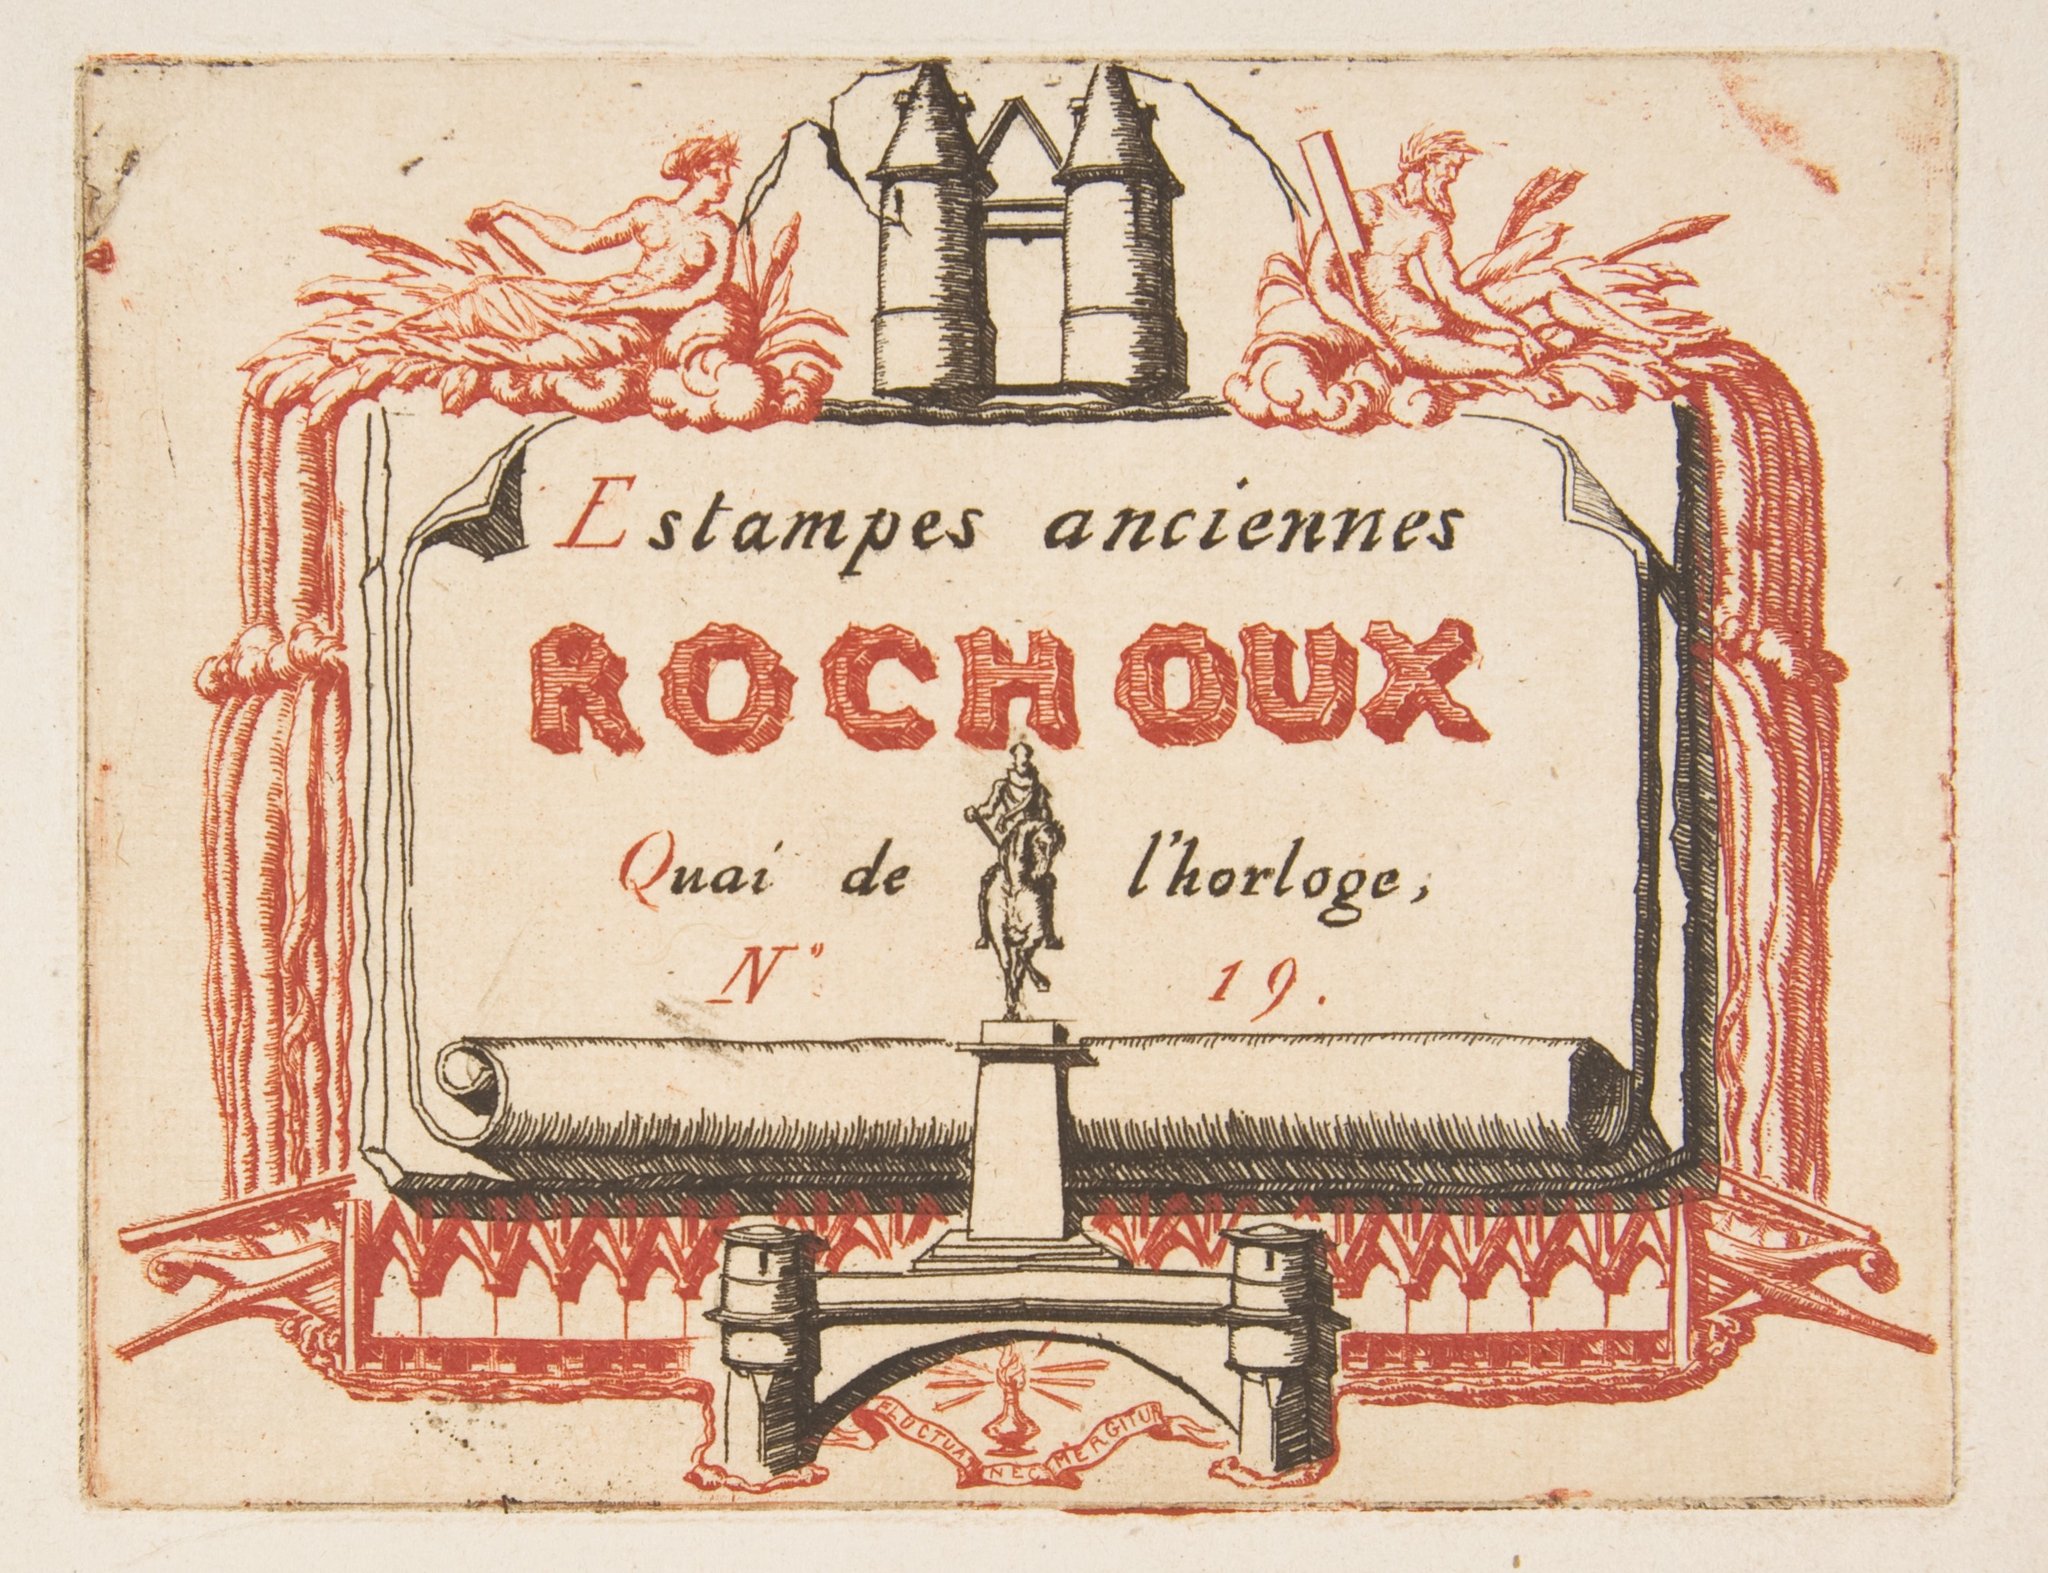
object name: print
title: Address-card of the printseller, Rochoux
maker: charles meryon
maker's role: artist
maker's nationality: french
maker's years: 1821-1868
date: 1855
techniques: etching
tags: men,women,horses